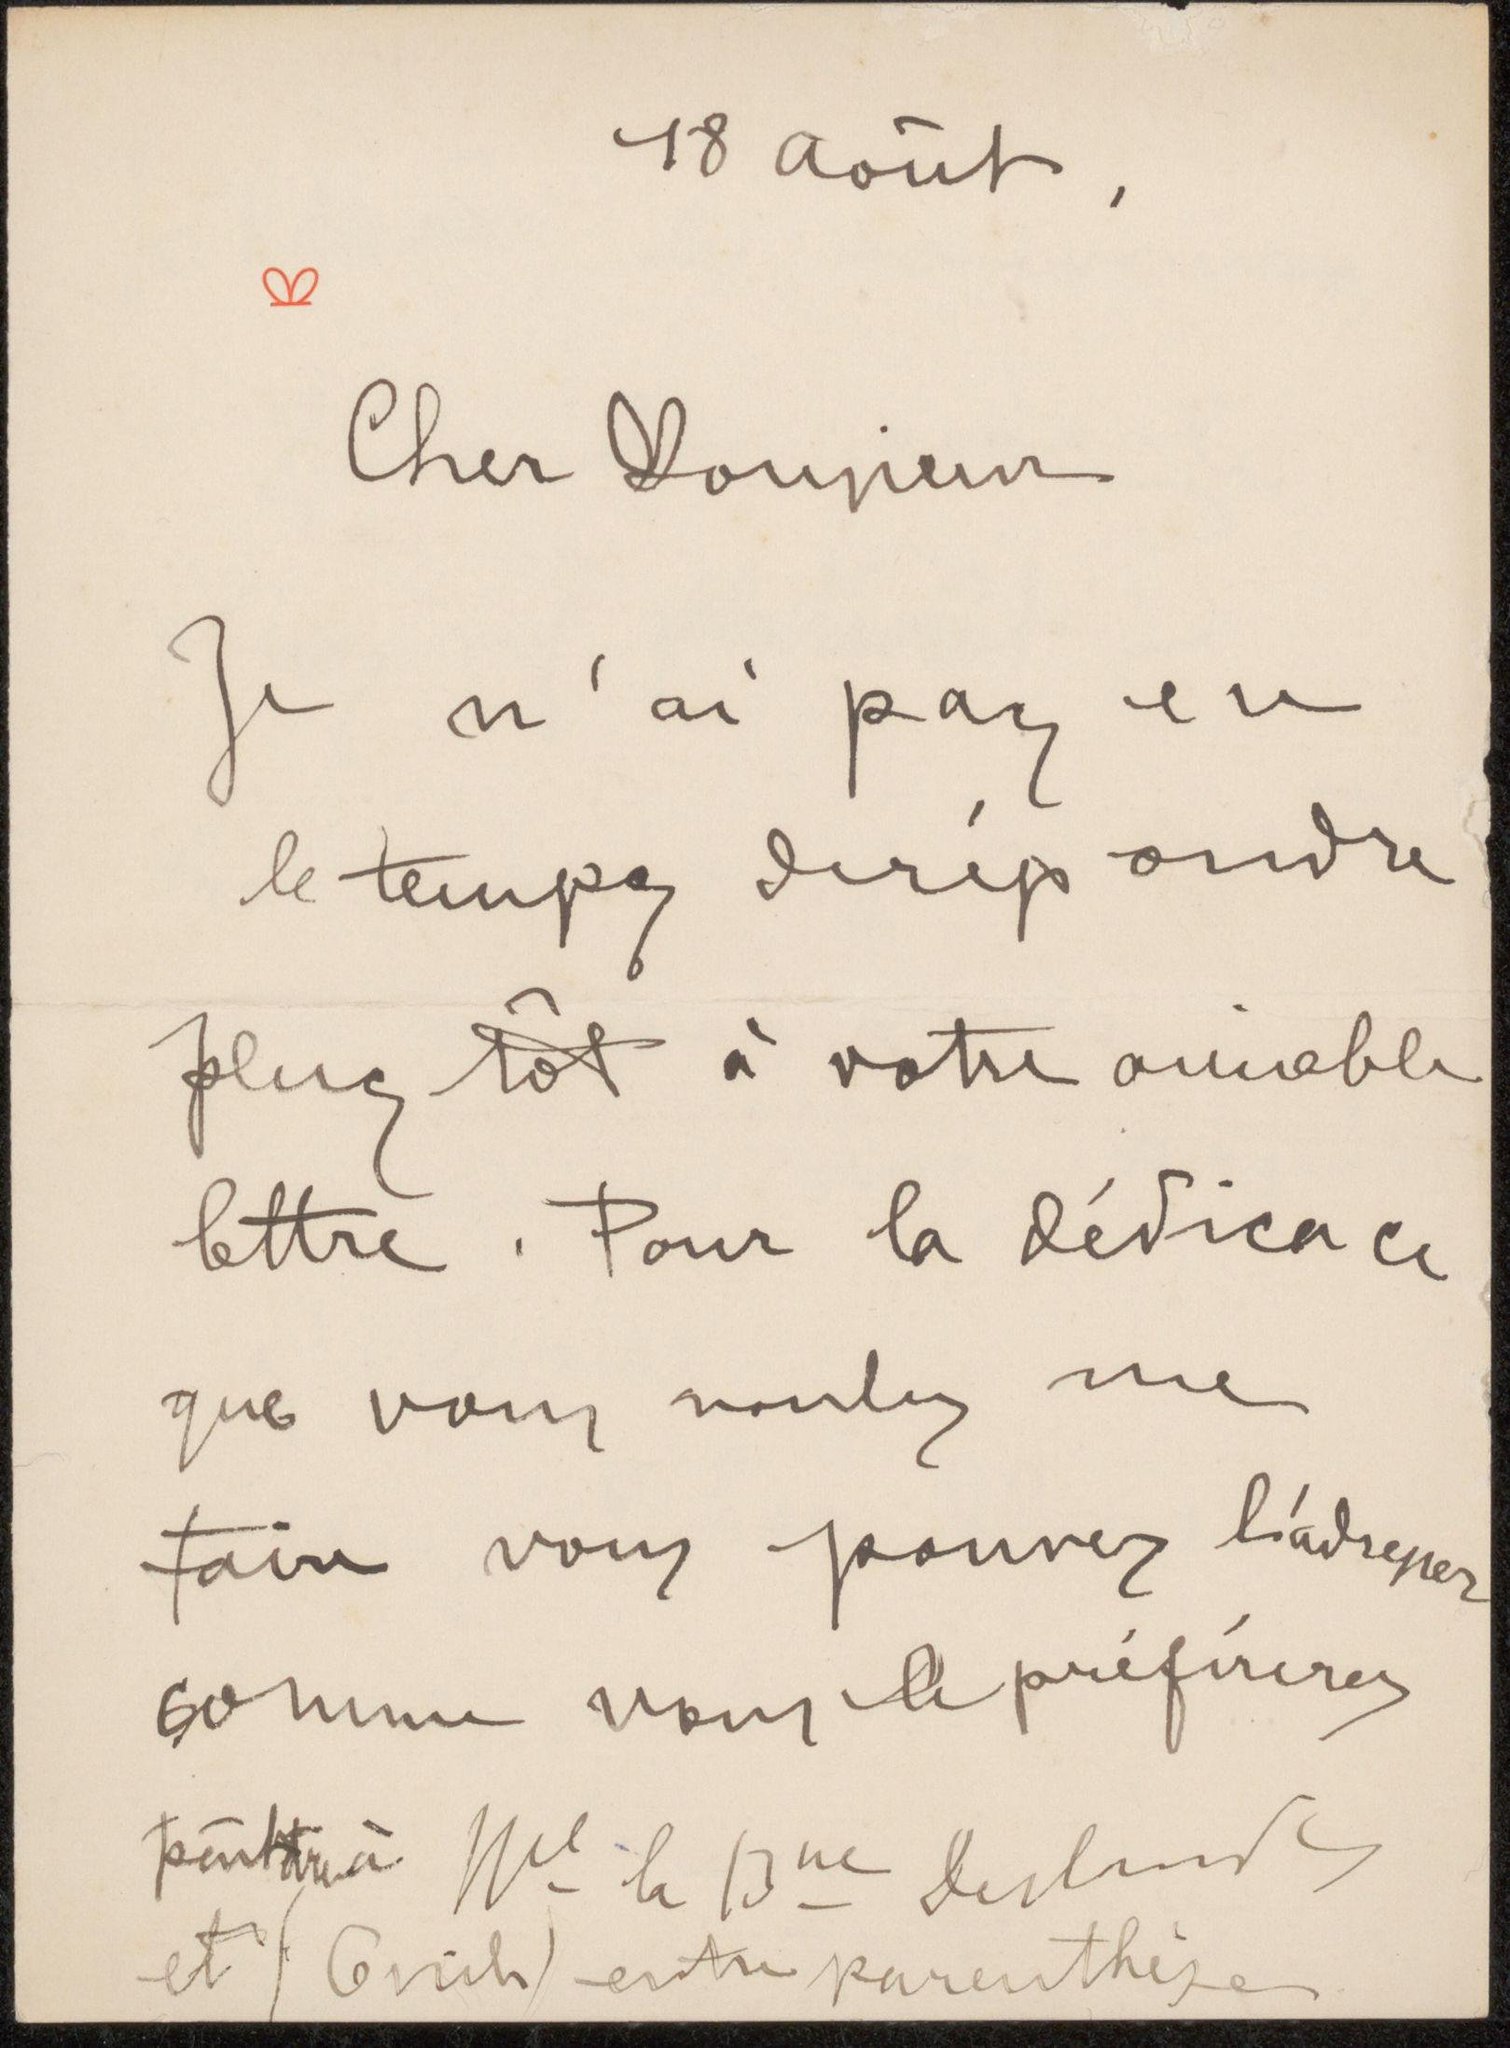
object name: letter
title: Brief aan Philip Zilcken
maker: baronne madeleine deslandes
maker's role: schrijver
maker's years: 1866-1929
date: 1900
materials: ink, paper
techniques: pen, writing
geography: paris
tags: the hague, painter, draughtsman, philip zilcken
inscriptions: collector's mark: ‘RPK’